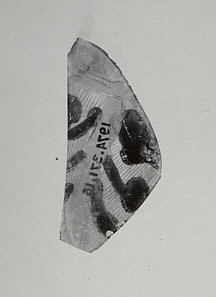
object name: fragment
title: Glass Fragment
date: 801-900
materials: glass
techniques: luster painting, stain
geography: egypt or iraq